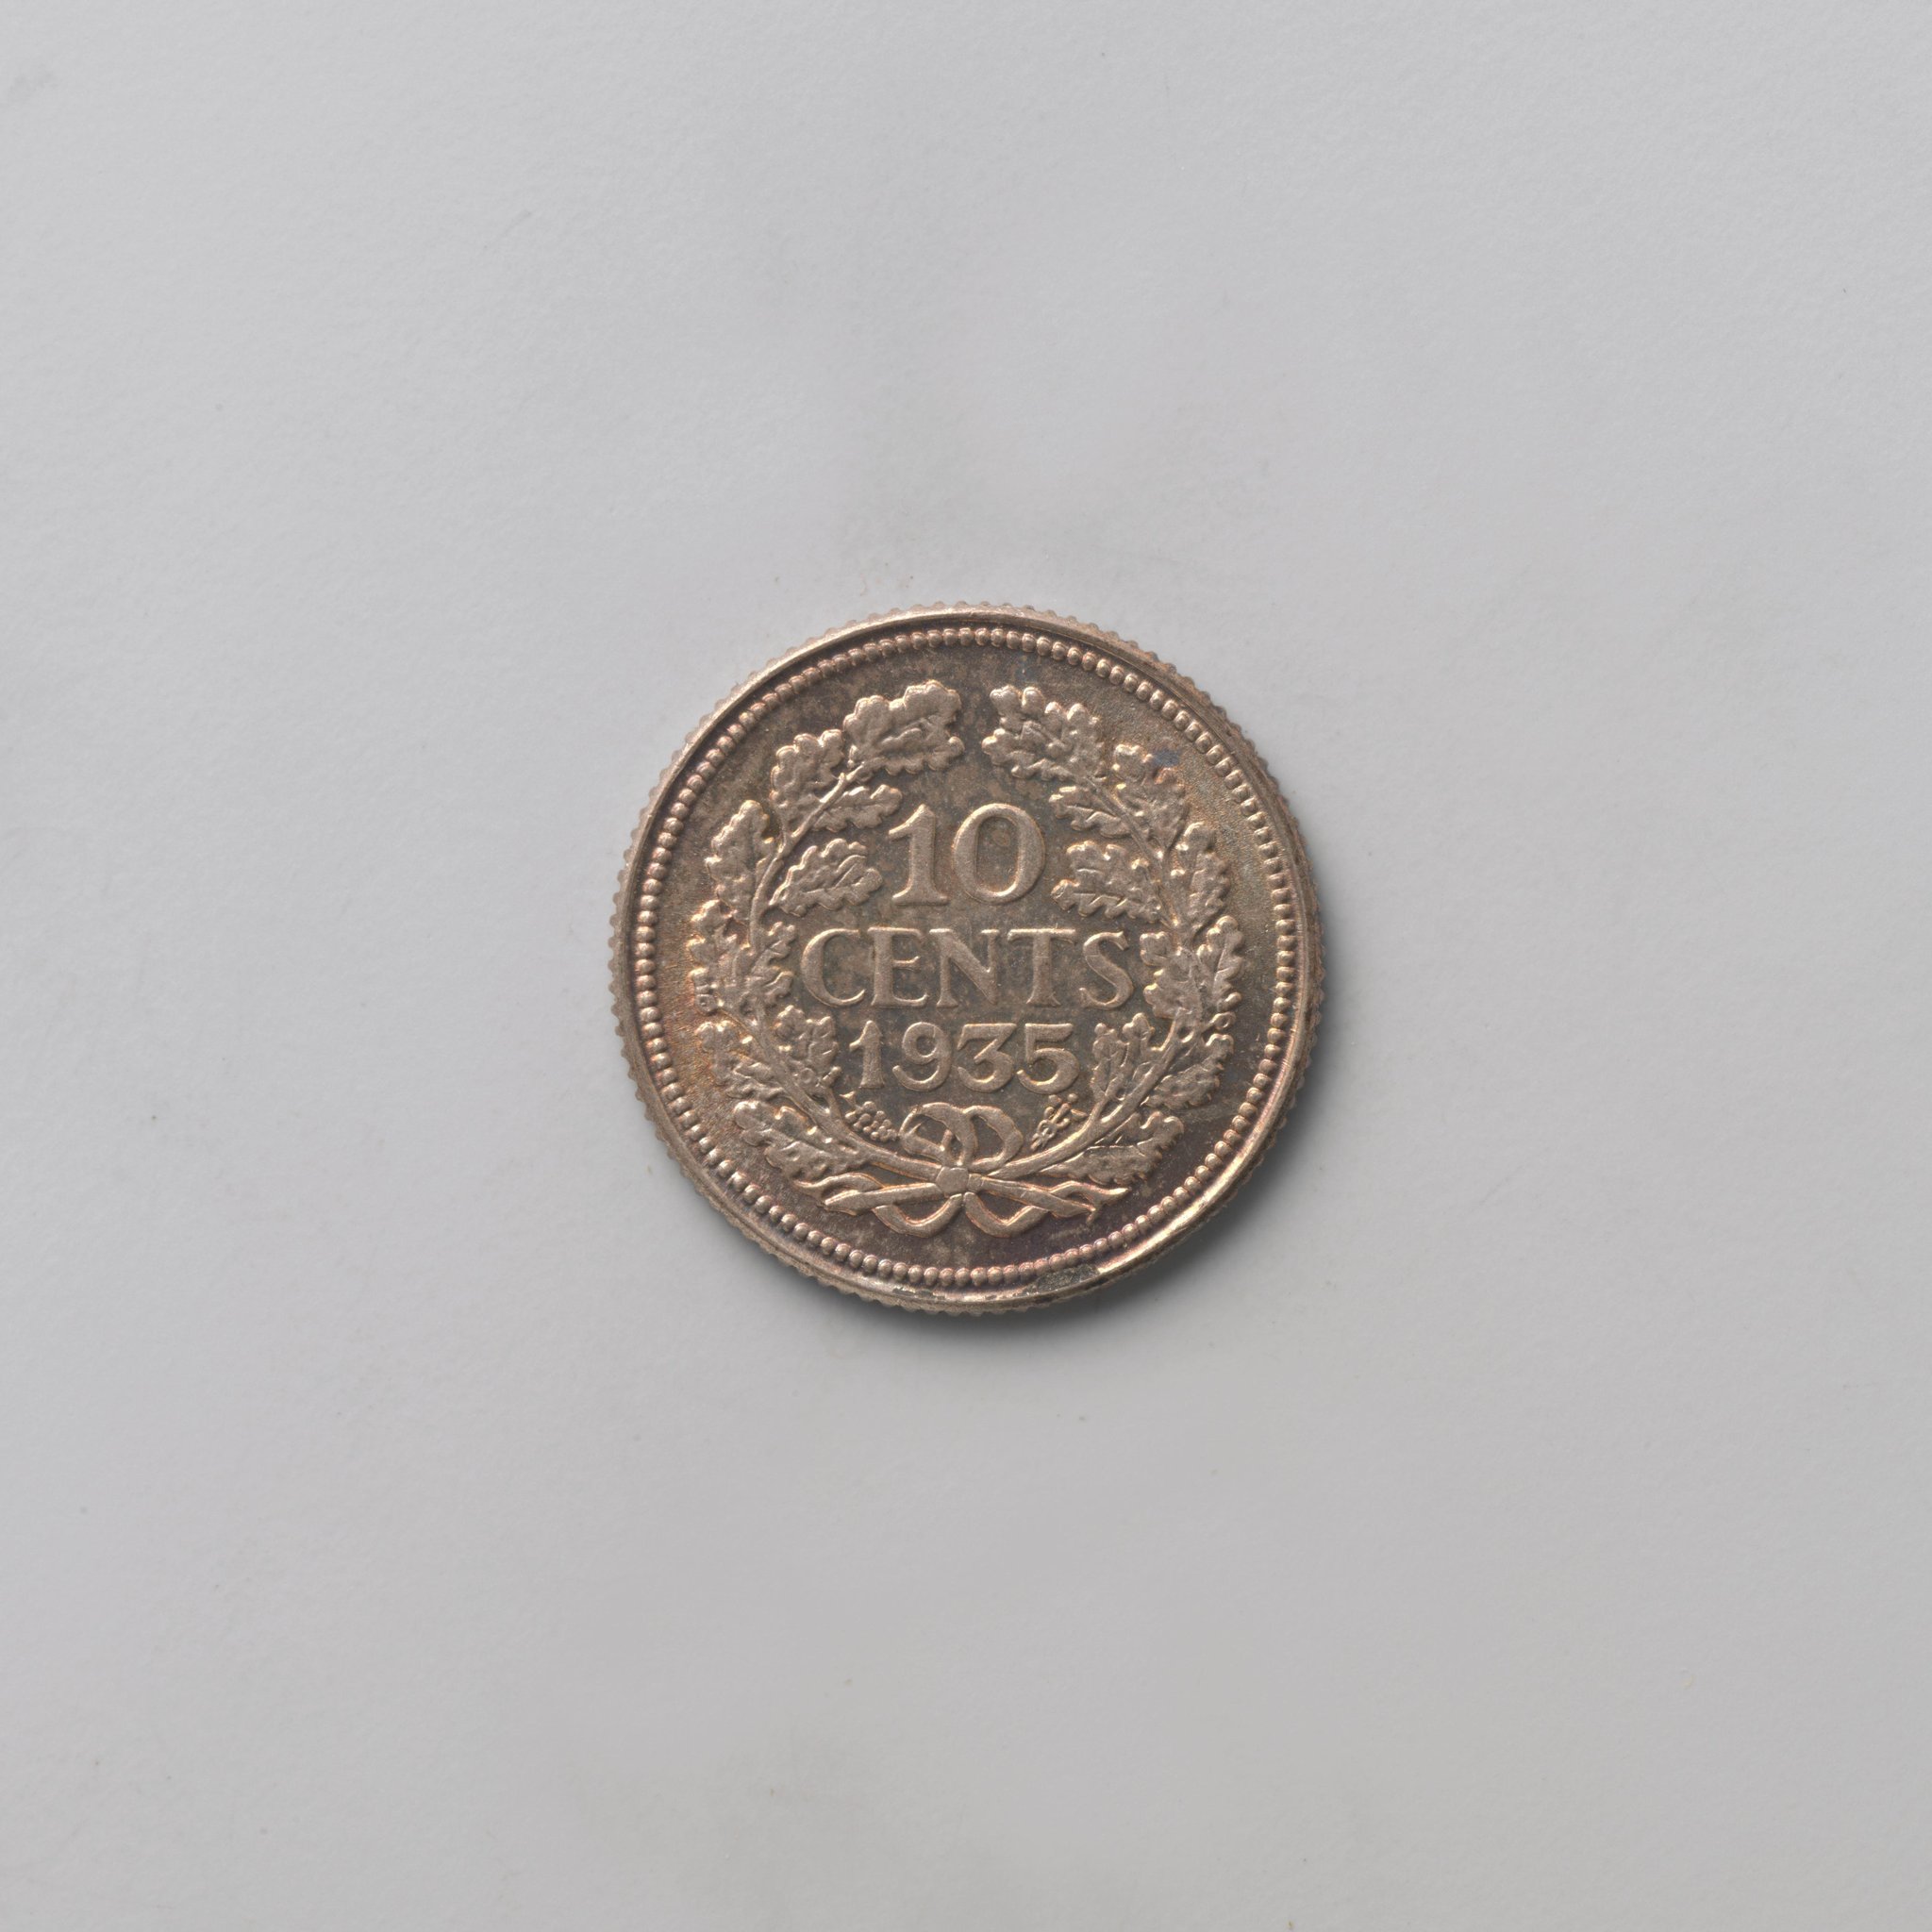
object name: coin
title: Nederland,10 cent,1935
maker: wilhelmina of the netherlands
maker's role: print maker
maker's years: 1880-1962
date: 1935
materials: silver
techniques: striking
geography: utrecht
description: Zilveren munt. Voorzijde: hoofd naar links. Keerzijde: binnen twee samengebonden eiketakken waarde-aanduiding 10 cents en jaartal. Kartelrand.